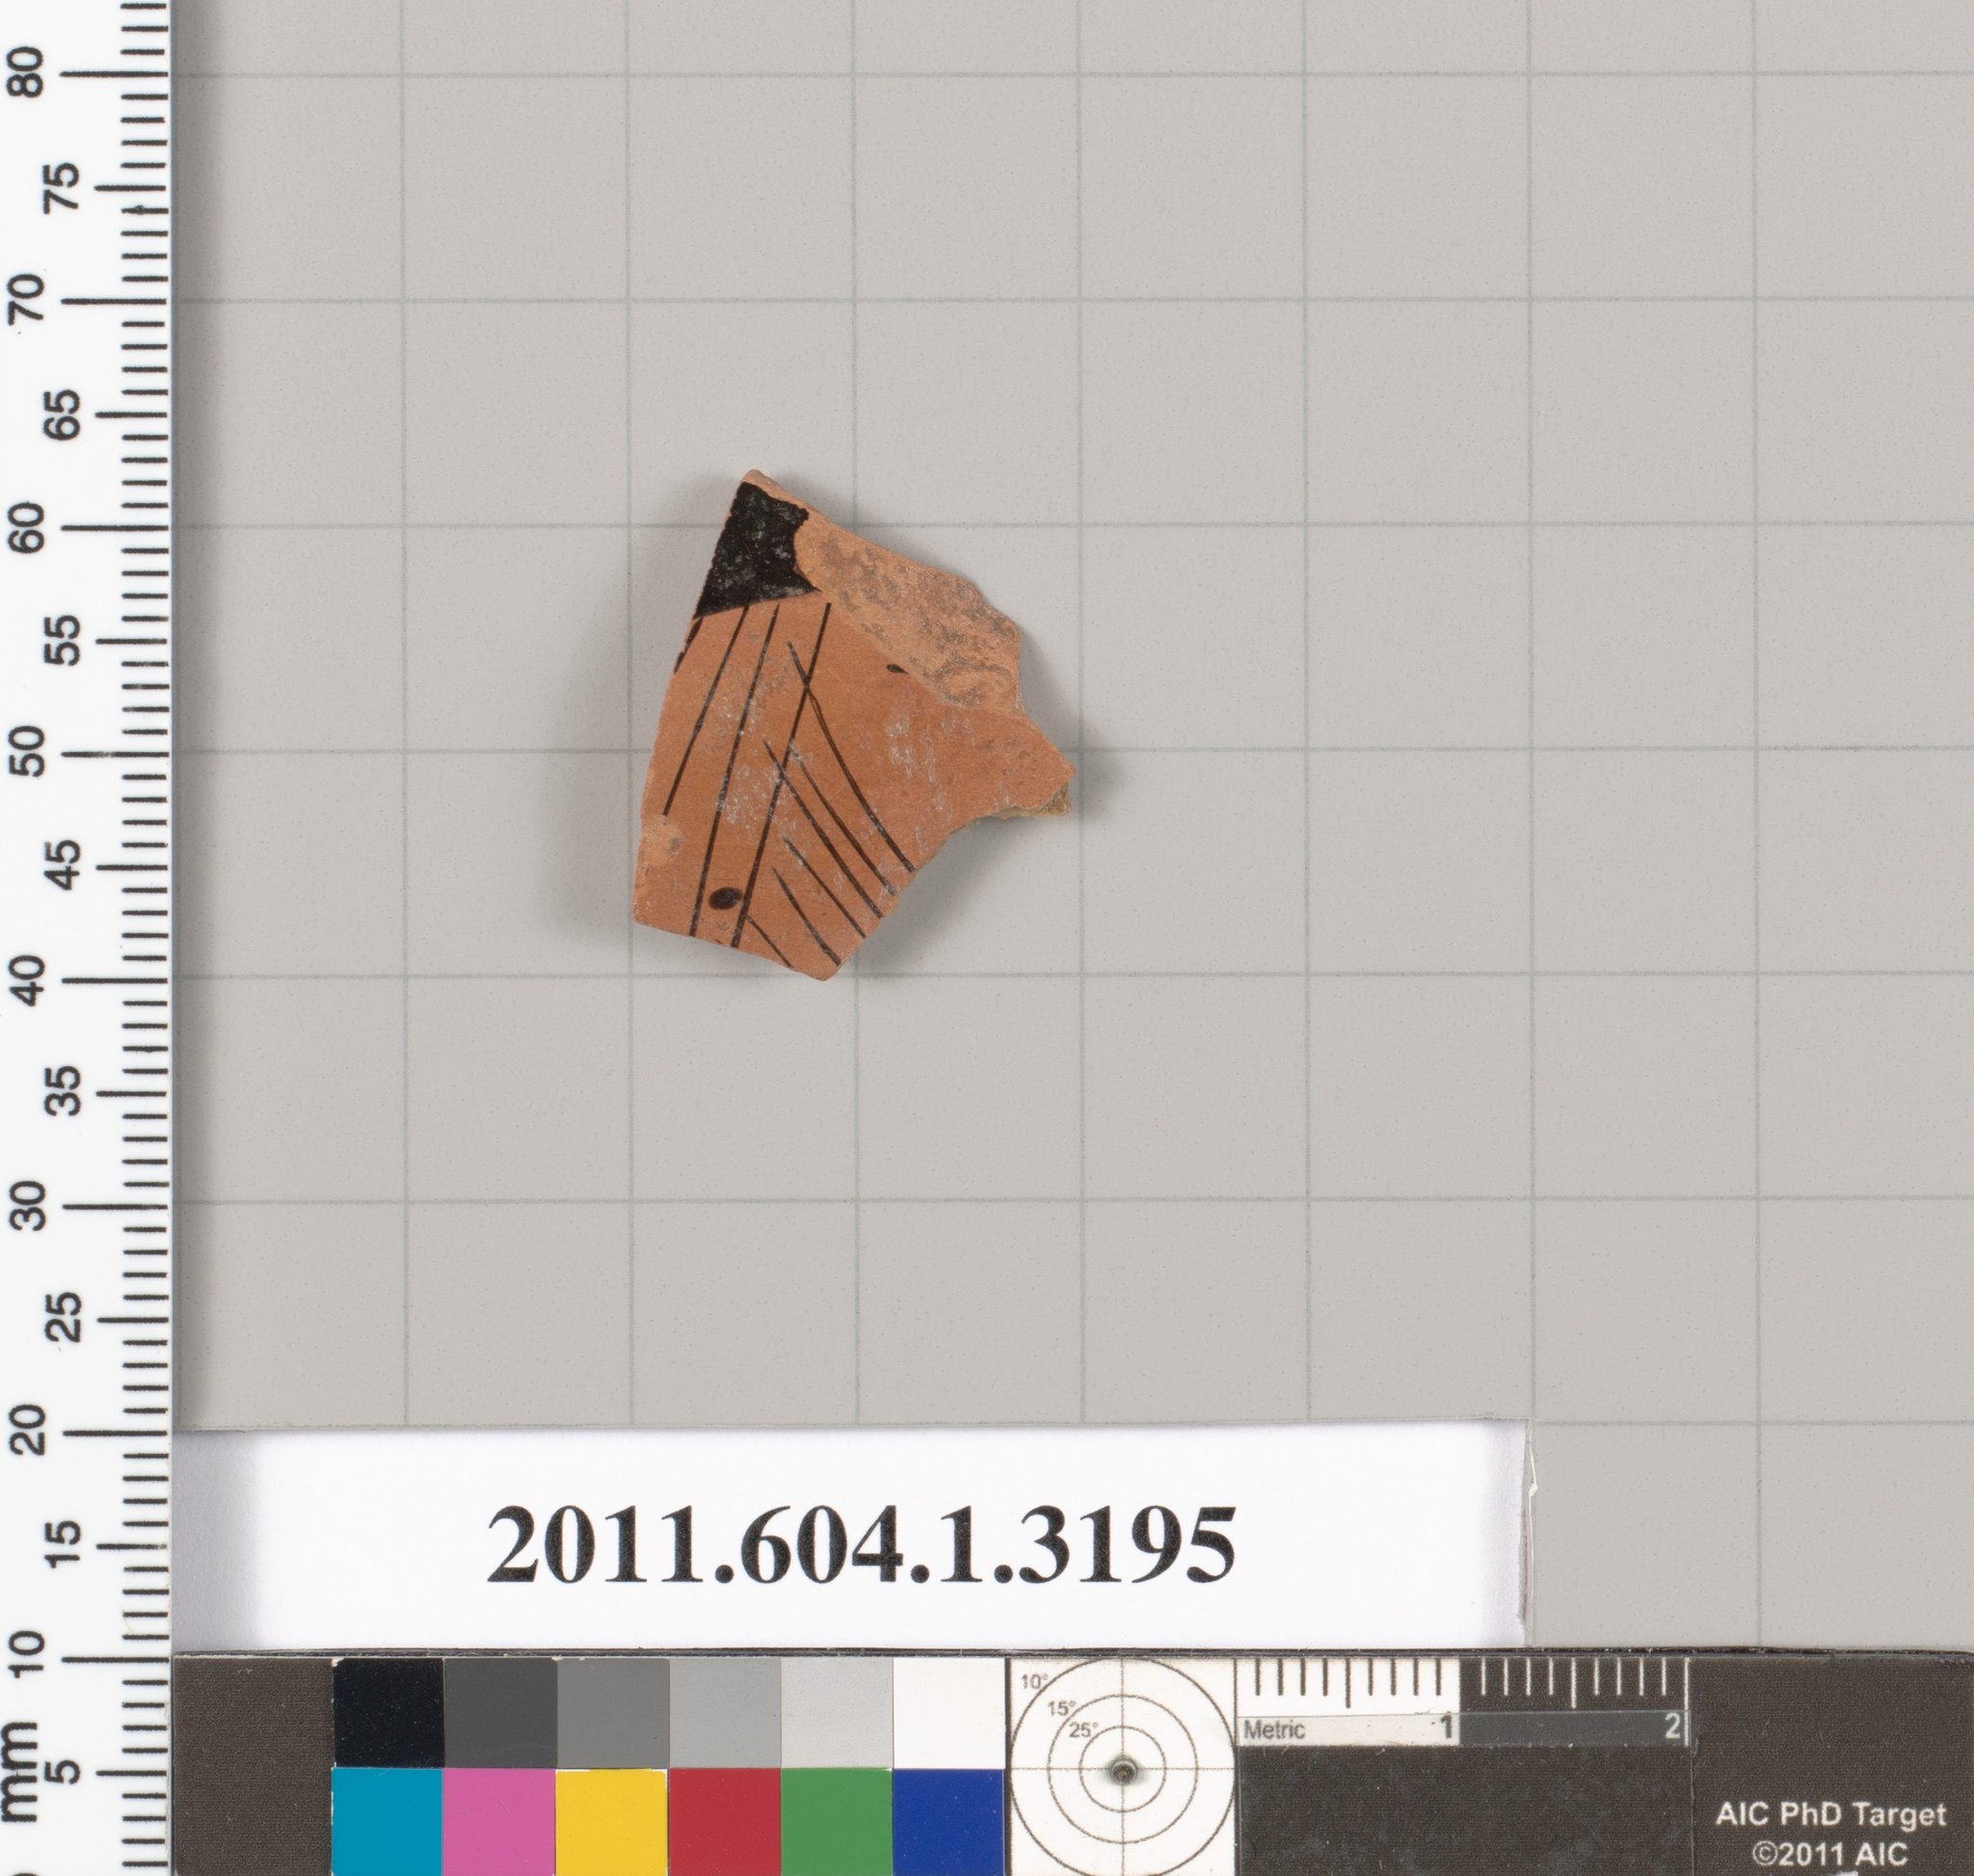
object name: kylix fragment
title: Terracotta fragment of a kylix (drinking cup)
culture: greek, attic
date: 467-435 BCE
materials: terracotta